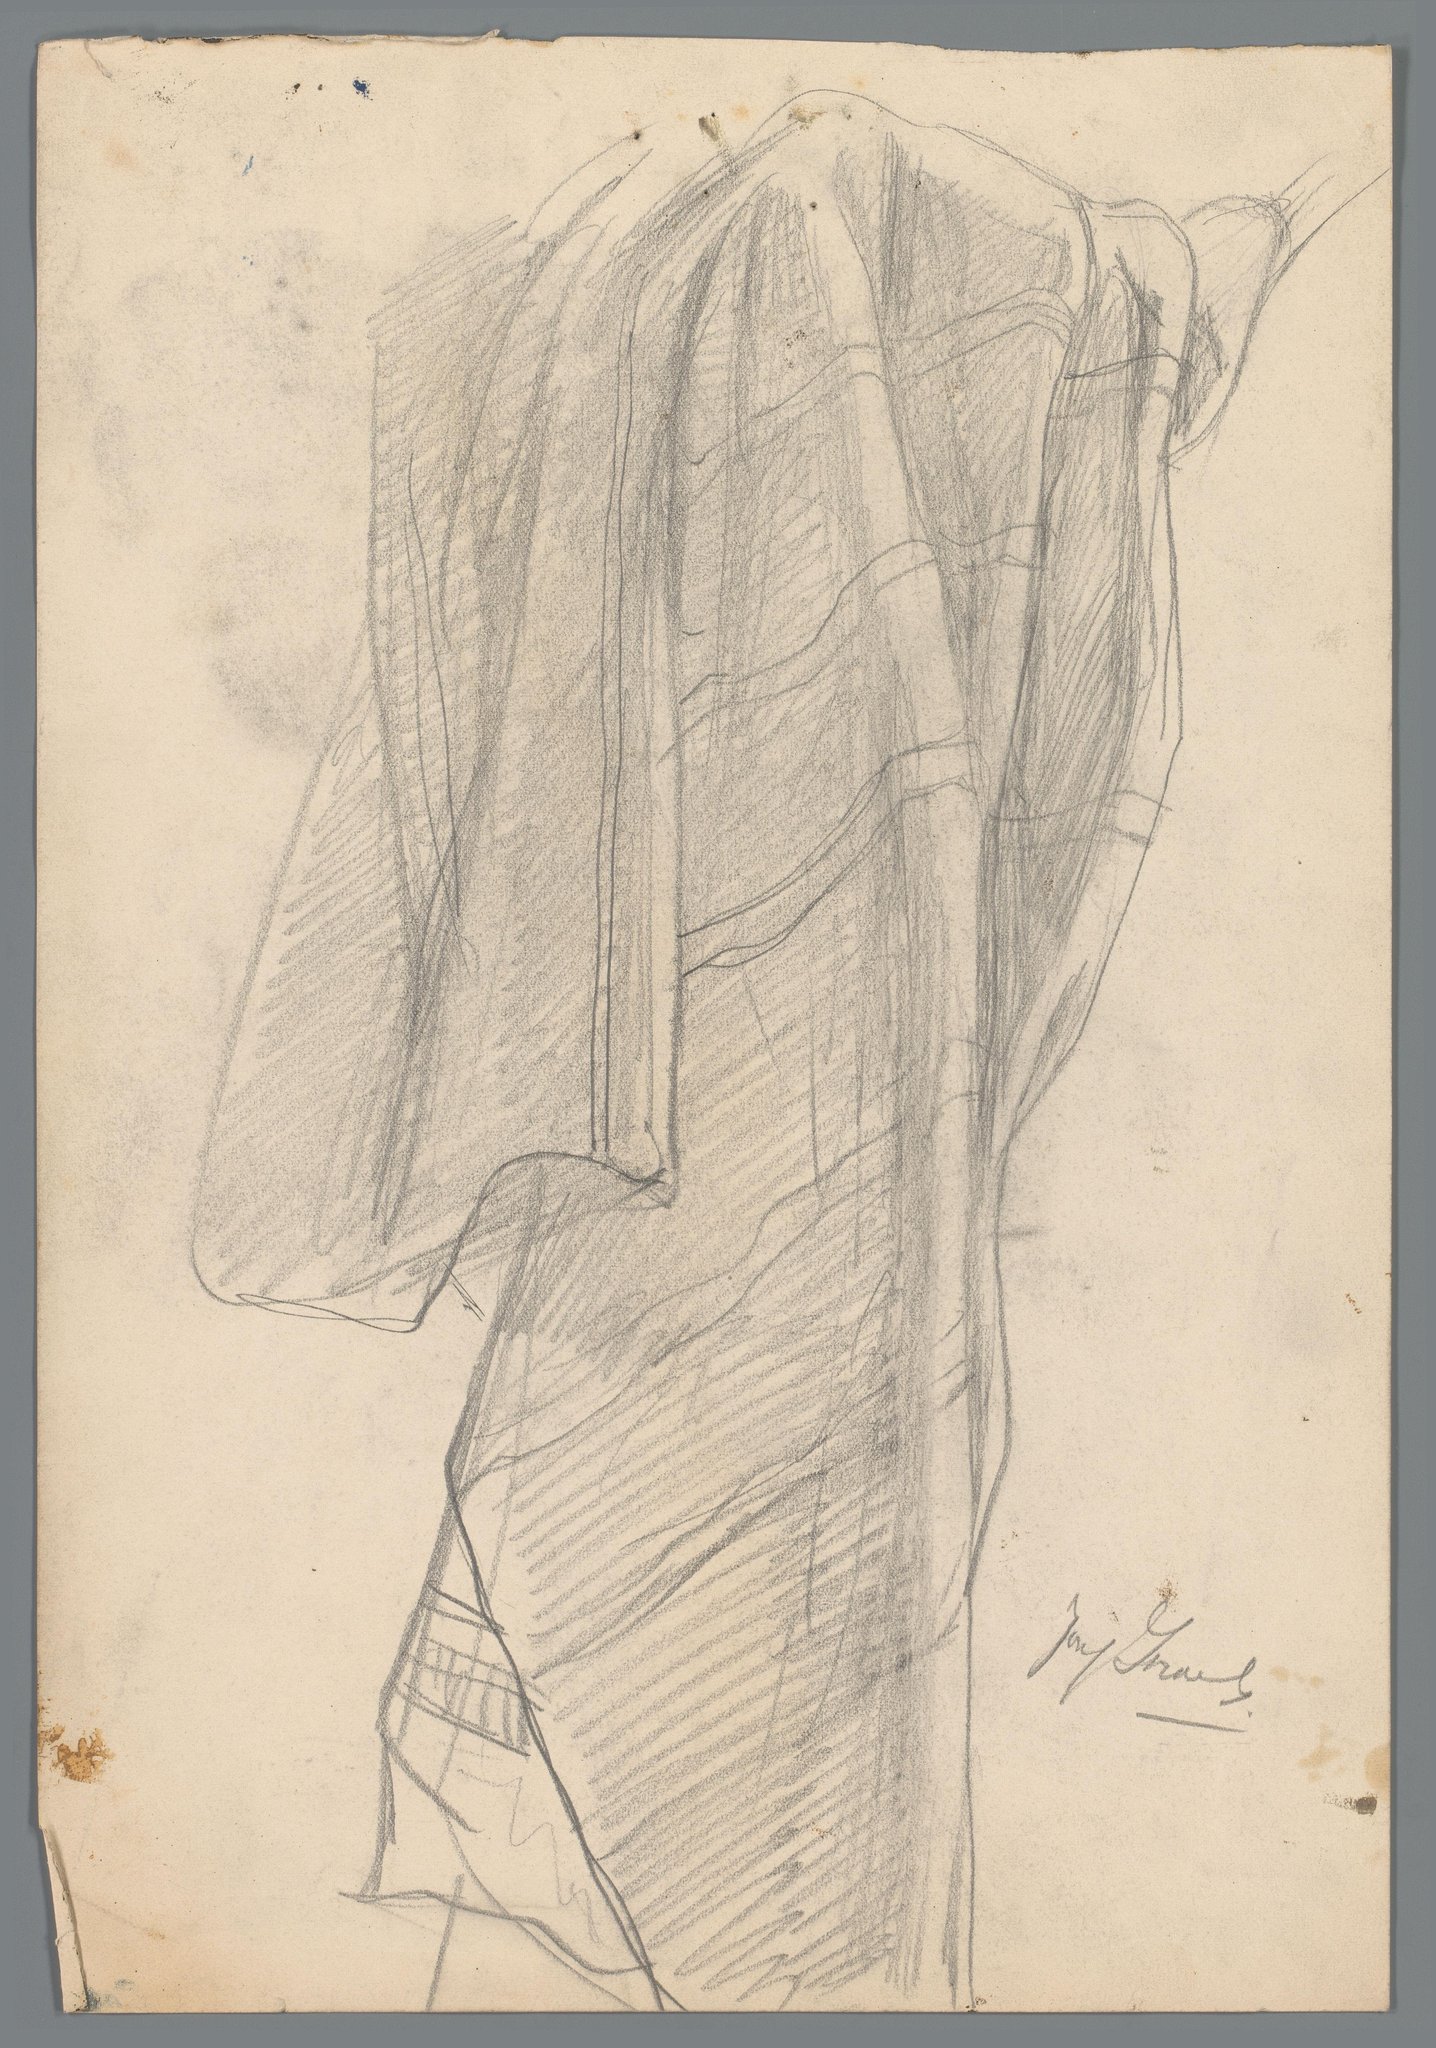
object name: drawing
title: Draperie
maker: jozef israëls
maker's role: draughtsman, painter, print maker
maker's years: 1824-1911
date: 1899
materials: paper, pencil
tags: drapery, draped garment, 'gewandgebung'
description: Mogelijk een voorstudie voor het schilderij 'David en Saul' dat zich in het Groninger Museum bevindt.